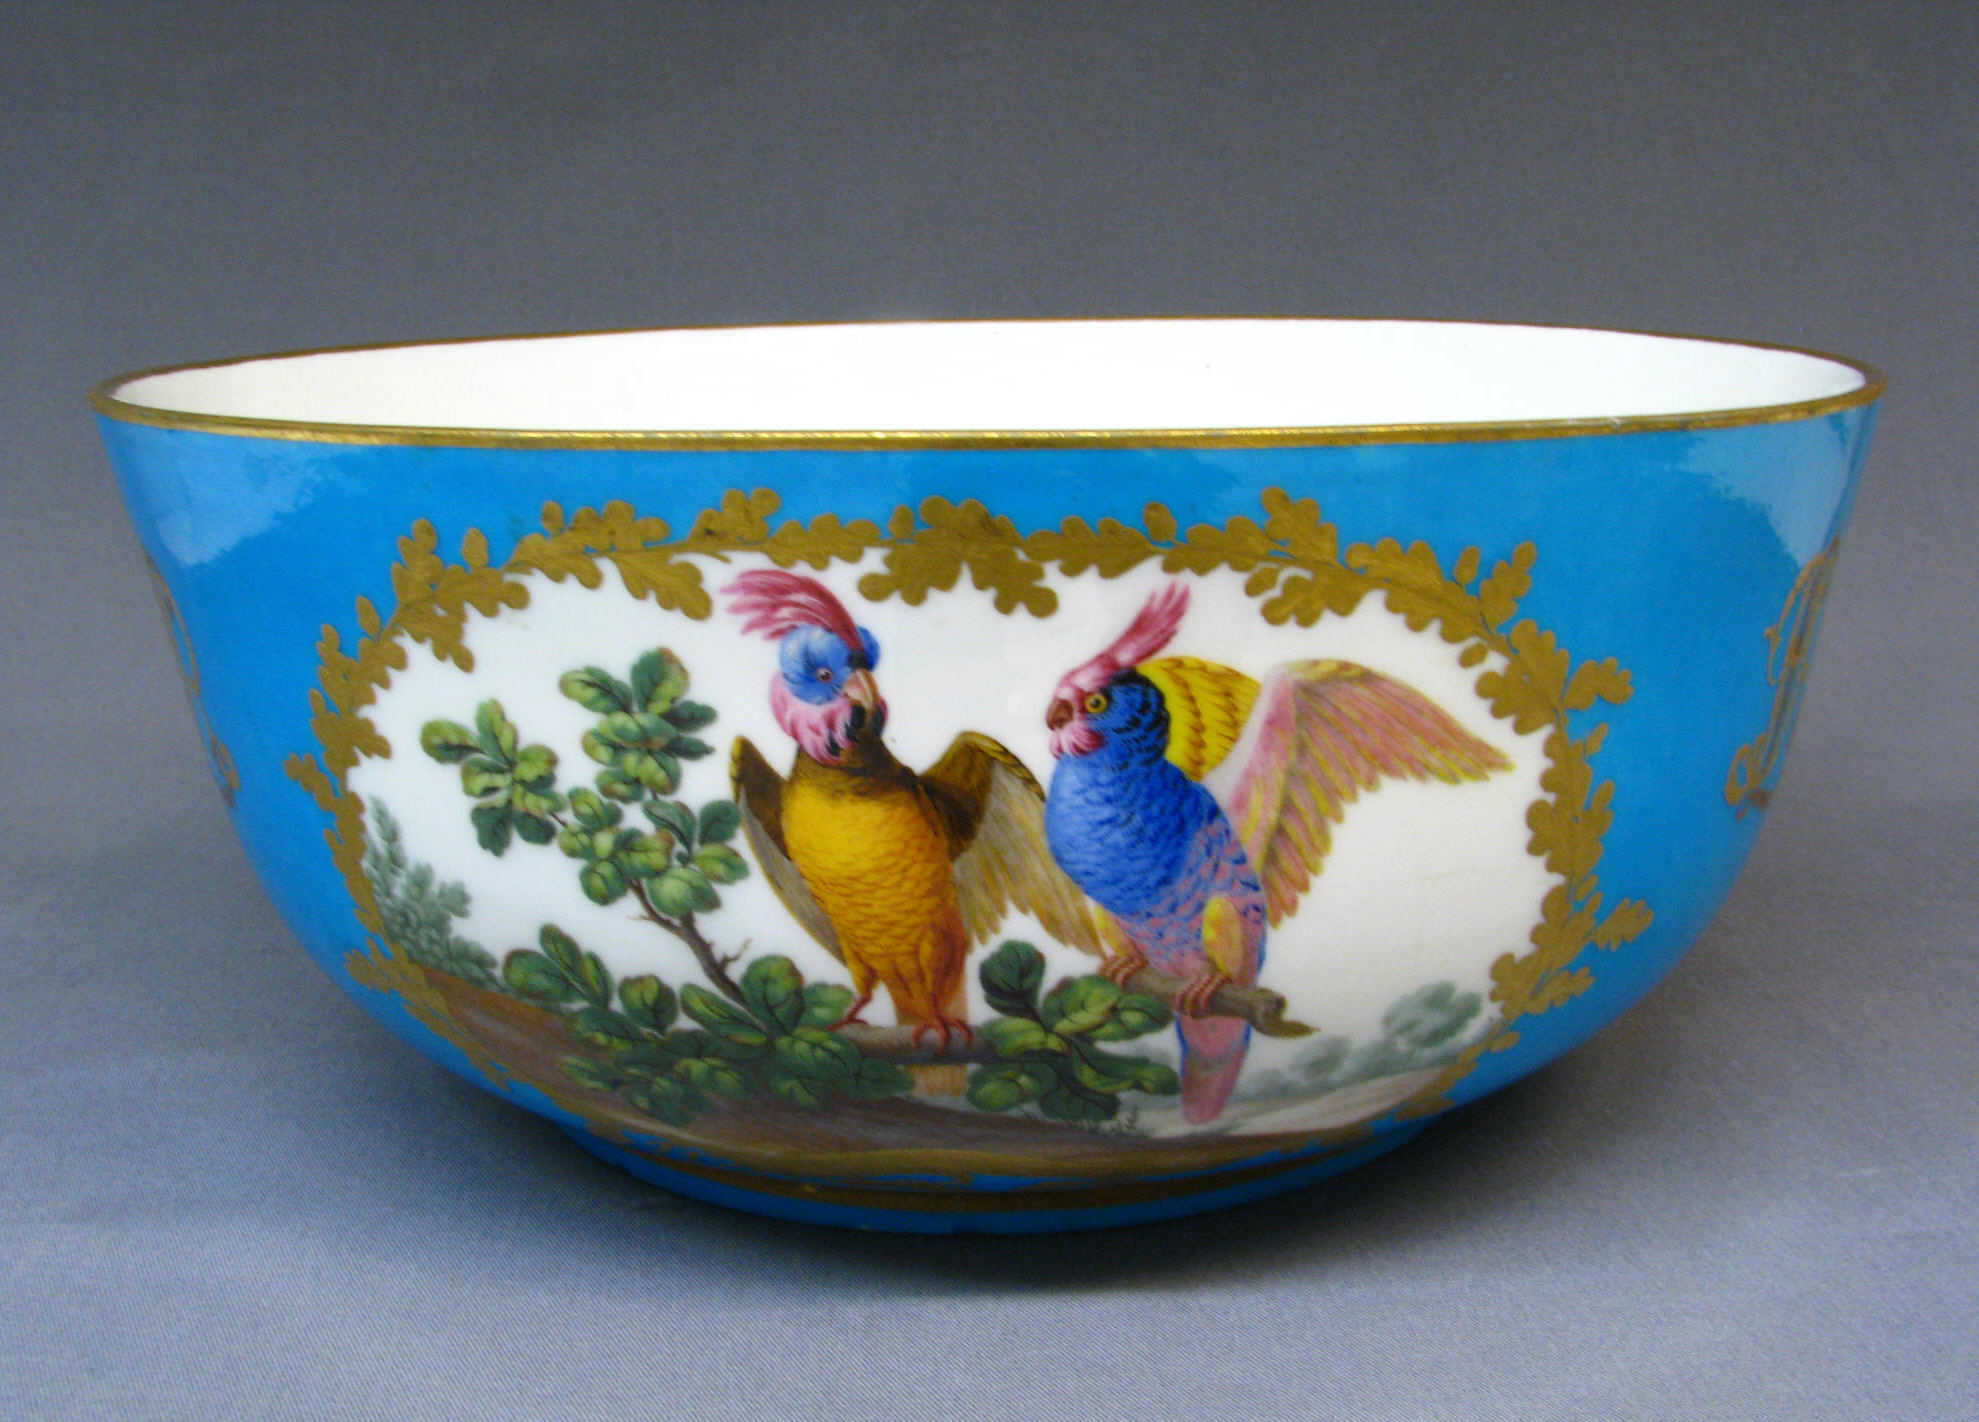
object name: punch bowl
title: Punch bowl (jatte à punch)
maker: sèvres manufactory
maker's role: manufactory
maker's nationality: french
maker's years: 1740-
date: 1772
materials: soft paste porcelain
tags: birds,acorns